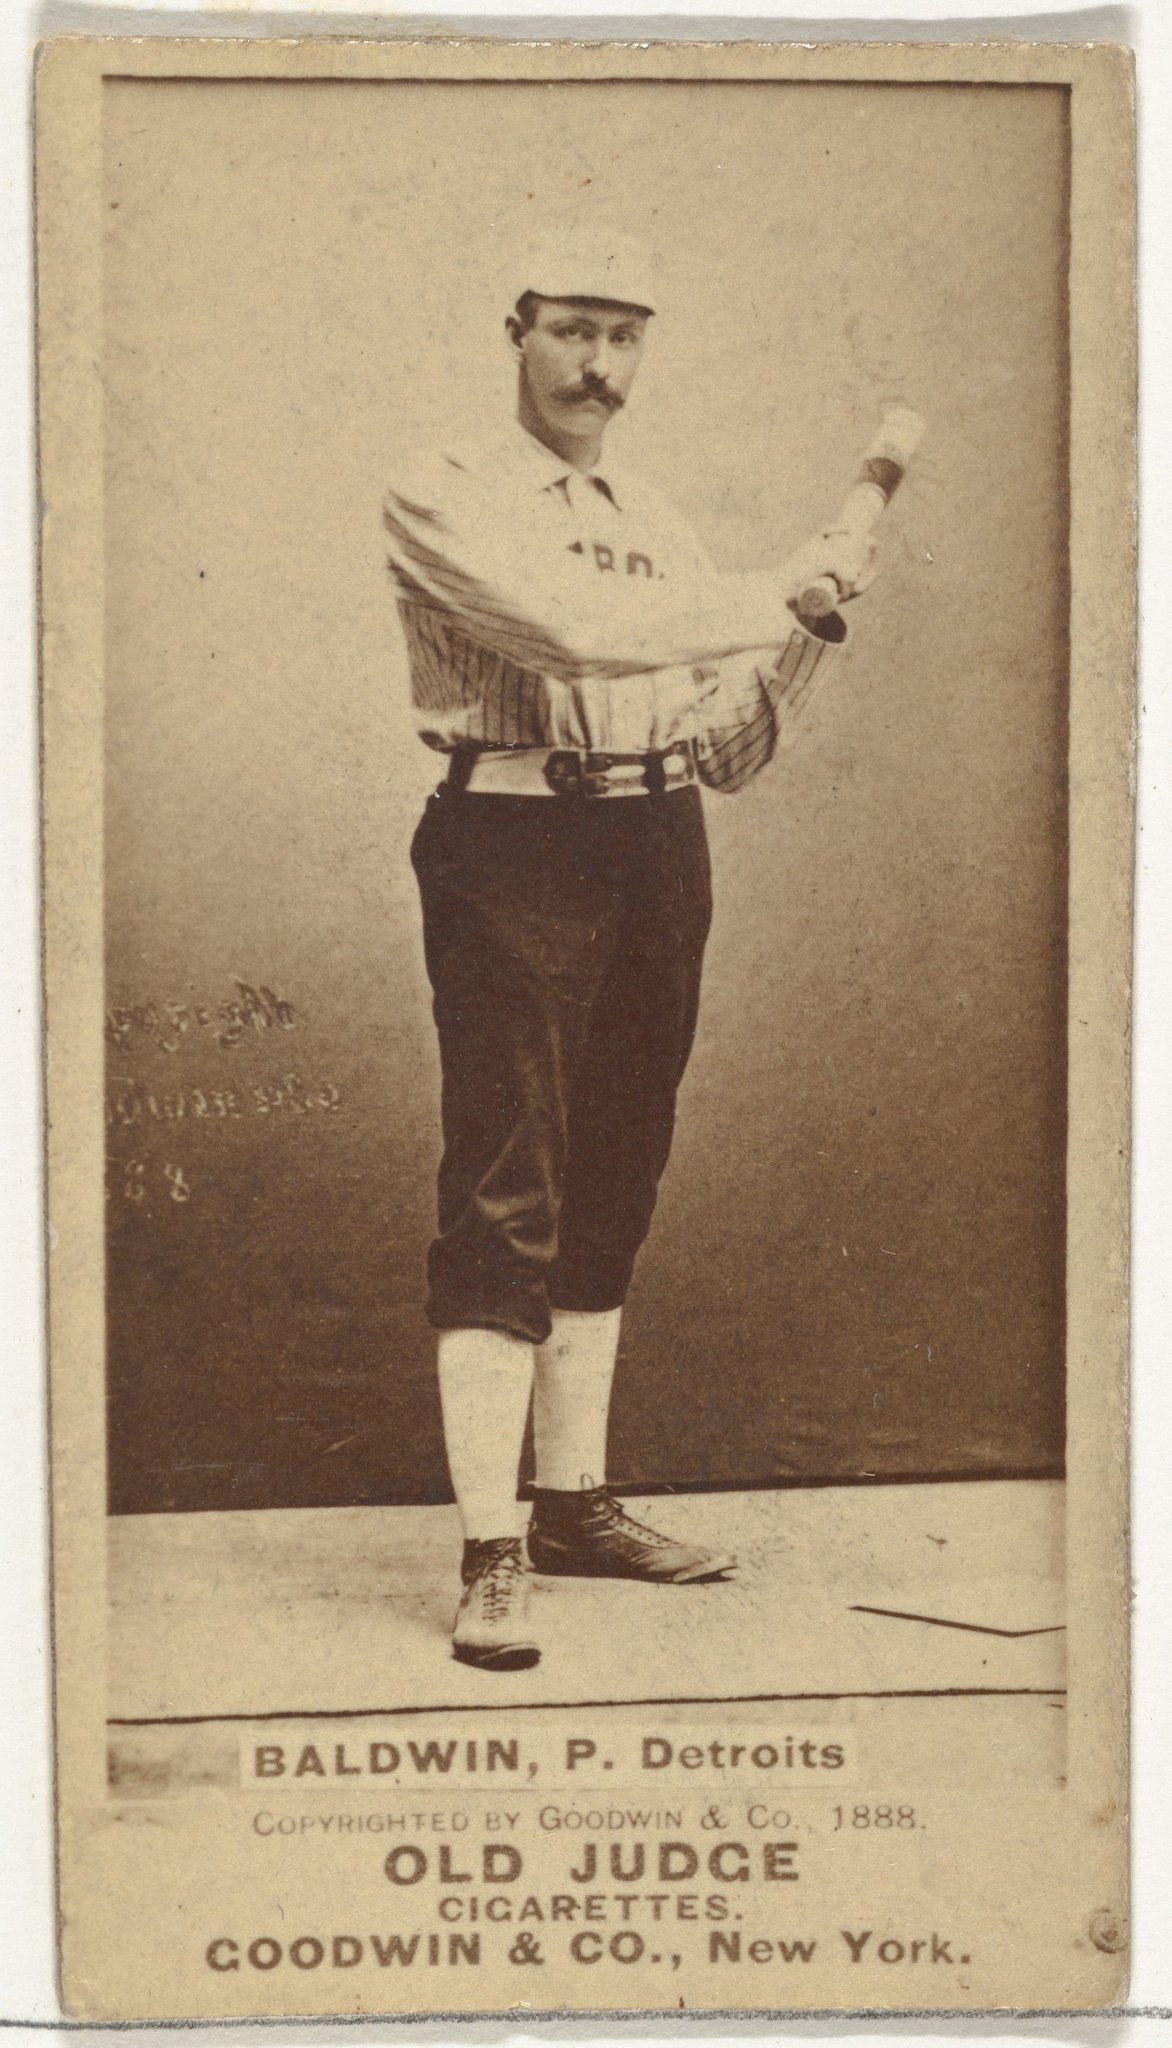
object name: baseball card, photograph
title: Charles B. "Lady" Baldwin, Pitcher, Detroit Wolverines, from the Old Judge series (N172) for Old Judge Cigarettes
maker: goodwin & company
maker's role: publisher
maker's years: 1850-1950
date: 1888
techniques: albumen silver print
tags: men,portraits,baseball,athletes